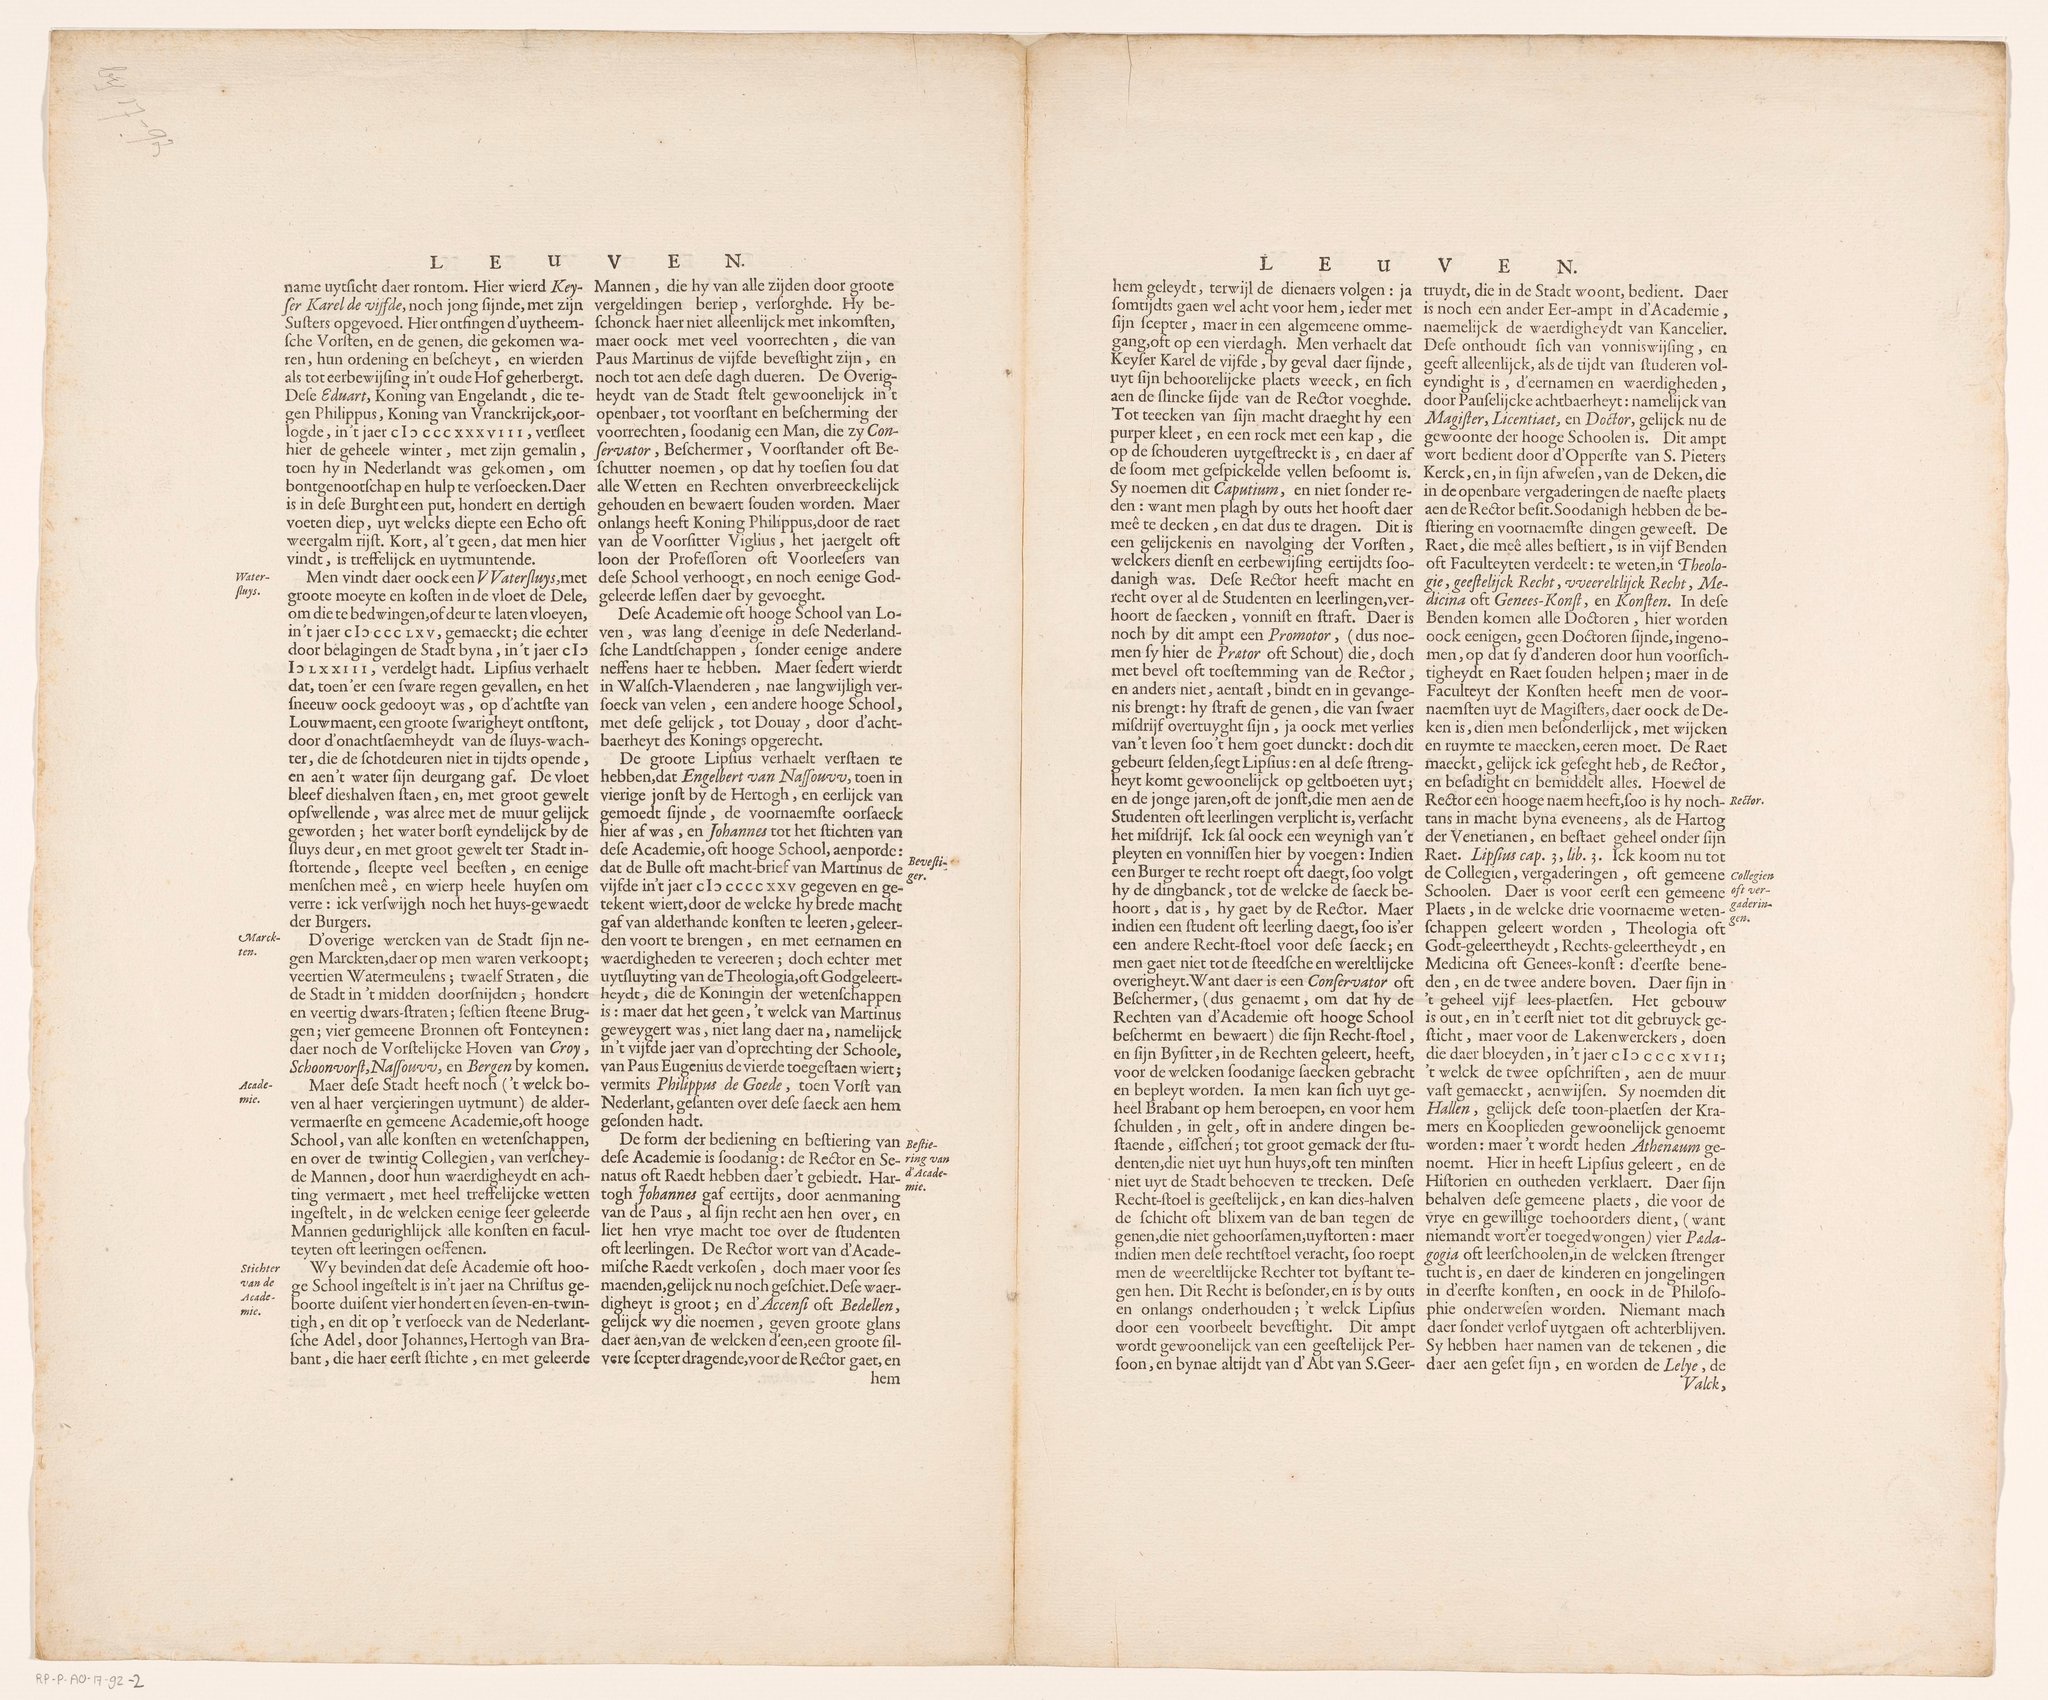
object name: text sheet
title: Leuven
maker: johannes willemszoon blaeu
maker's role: printer, publisher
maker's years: 1596-1673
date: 1652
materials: paper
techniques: letterpress printing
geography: amsterdam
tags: louvain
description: Tekst gebruikt in: Blaeu, Johannes Willemszoon. Toonneel der steden van de Vereenighde Nederlanden. 2 delen. Amsterdam: Johannes Willemszoon Blaeu, 1652, dl. 2. Zie ook: RP-P-AO-17-92-1 en RP-P-AO-17-92-3.